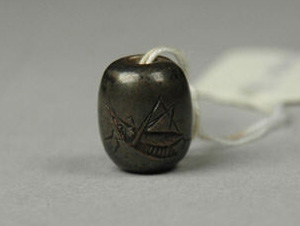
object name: ojime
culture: japanese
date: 1801-1900